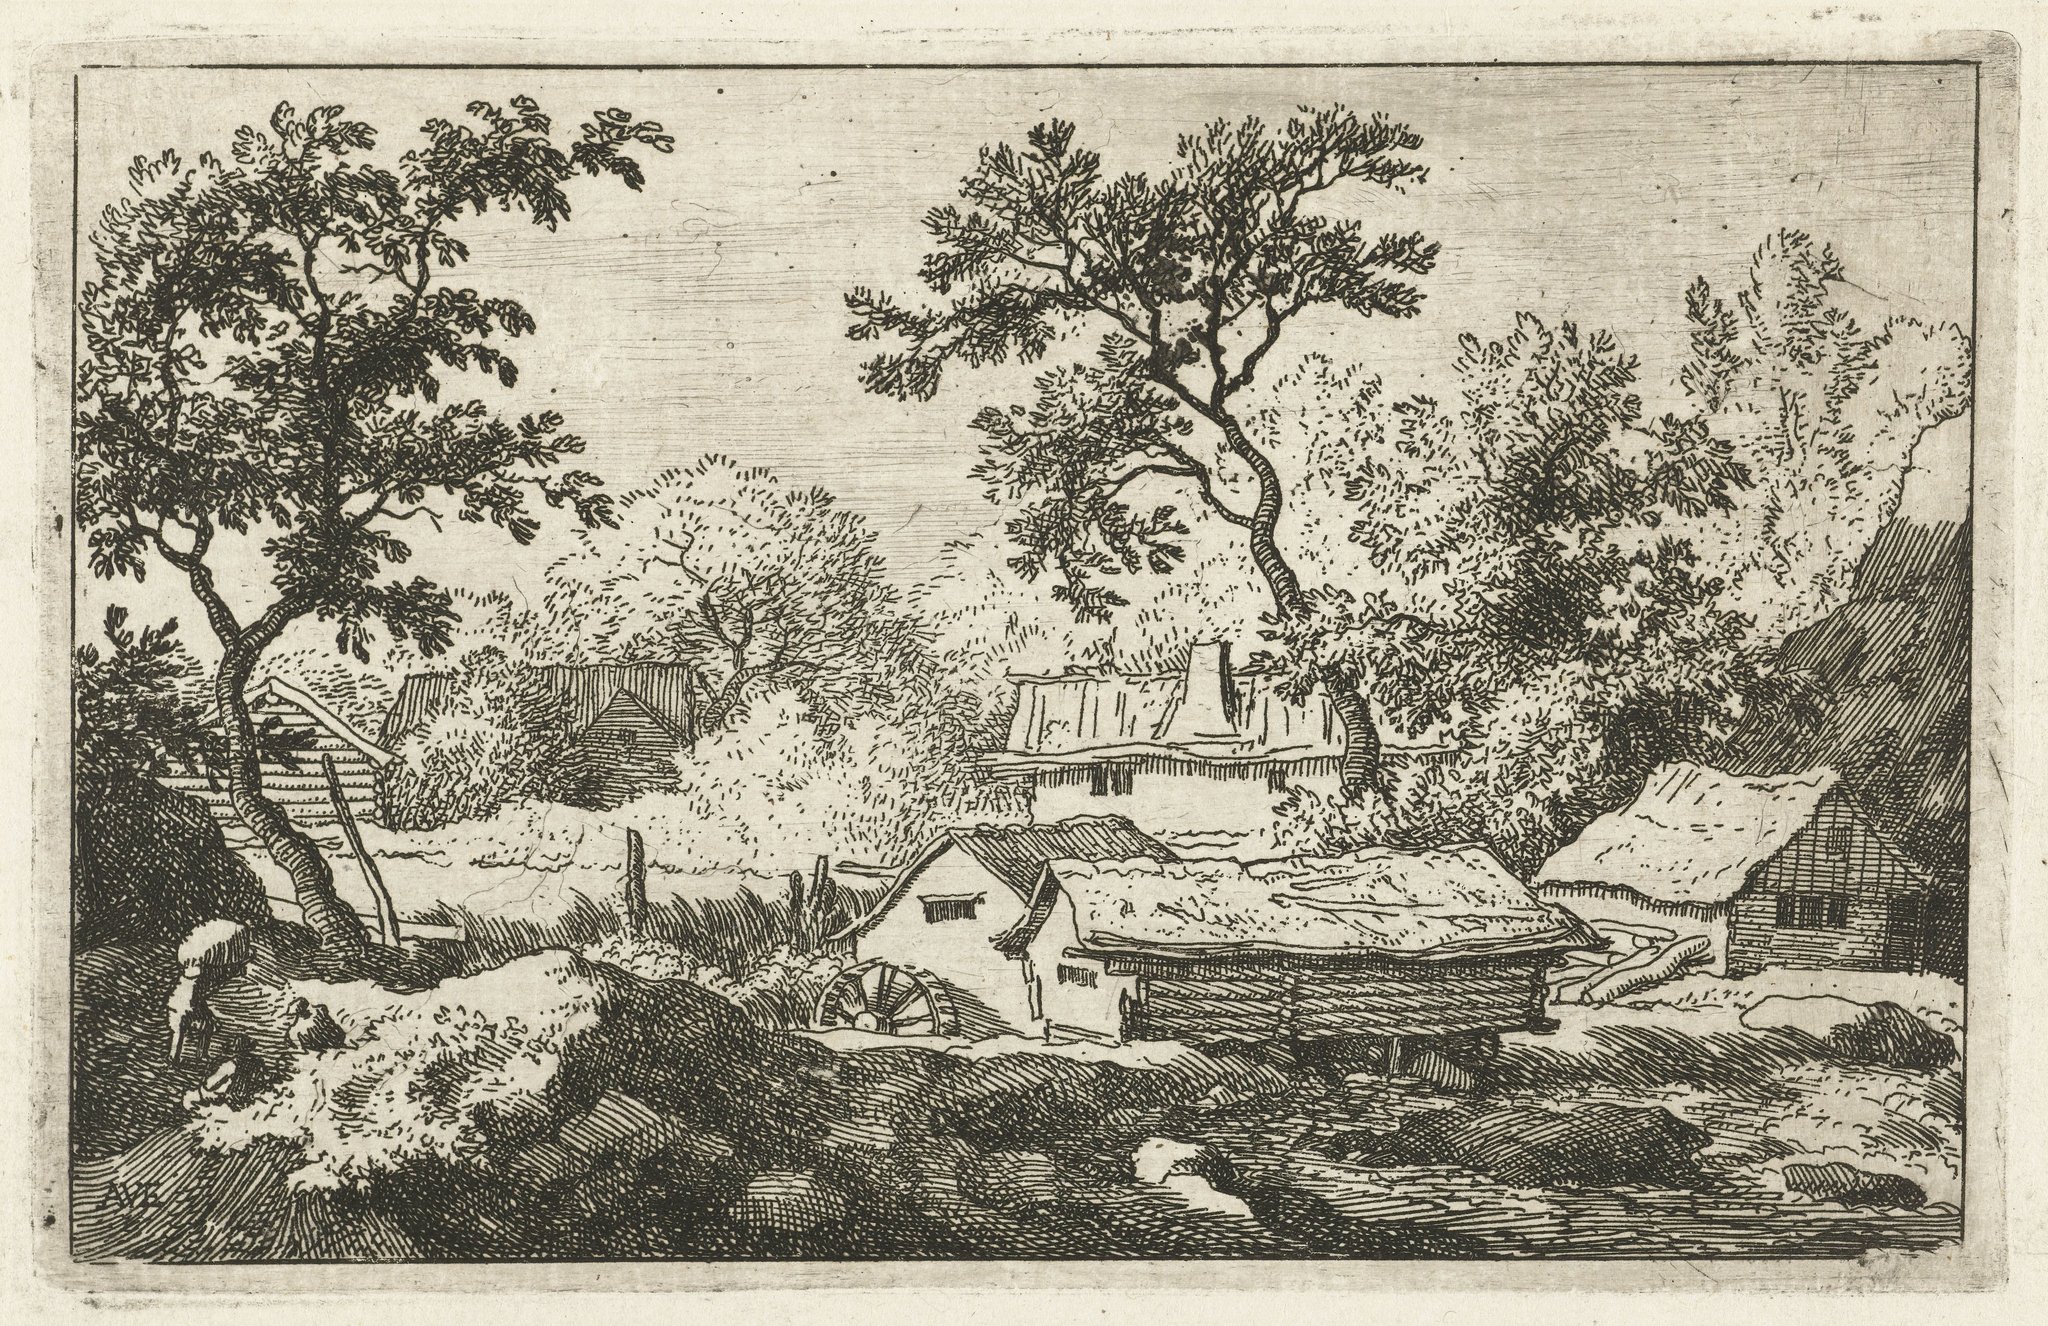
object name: print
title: Landschap met watermolen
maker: allaert van everdingen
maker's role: draughtsman, painter, print maker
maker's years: 1621-1675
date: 1631-1675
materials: paper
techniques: etching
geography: netherlands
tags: watermill in landscape (+ city(-scape) with figures, staffage)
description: Gezicht op enkele huizen en een watermolen bij een waterval. Tegen een kleine heuvel op de voorgrond zitten twee personen, terwijl een derde iets op zijn rug sjouwt.